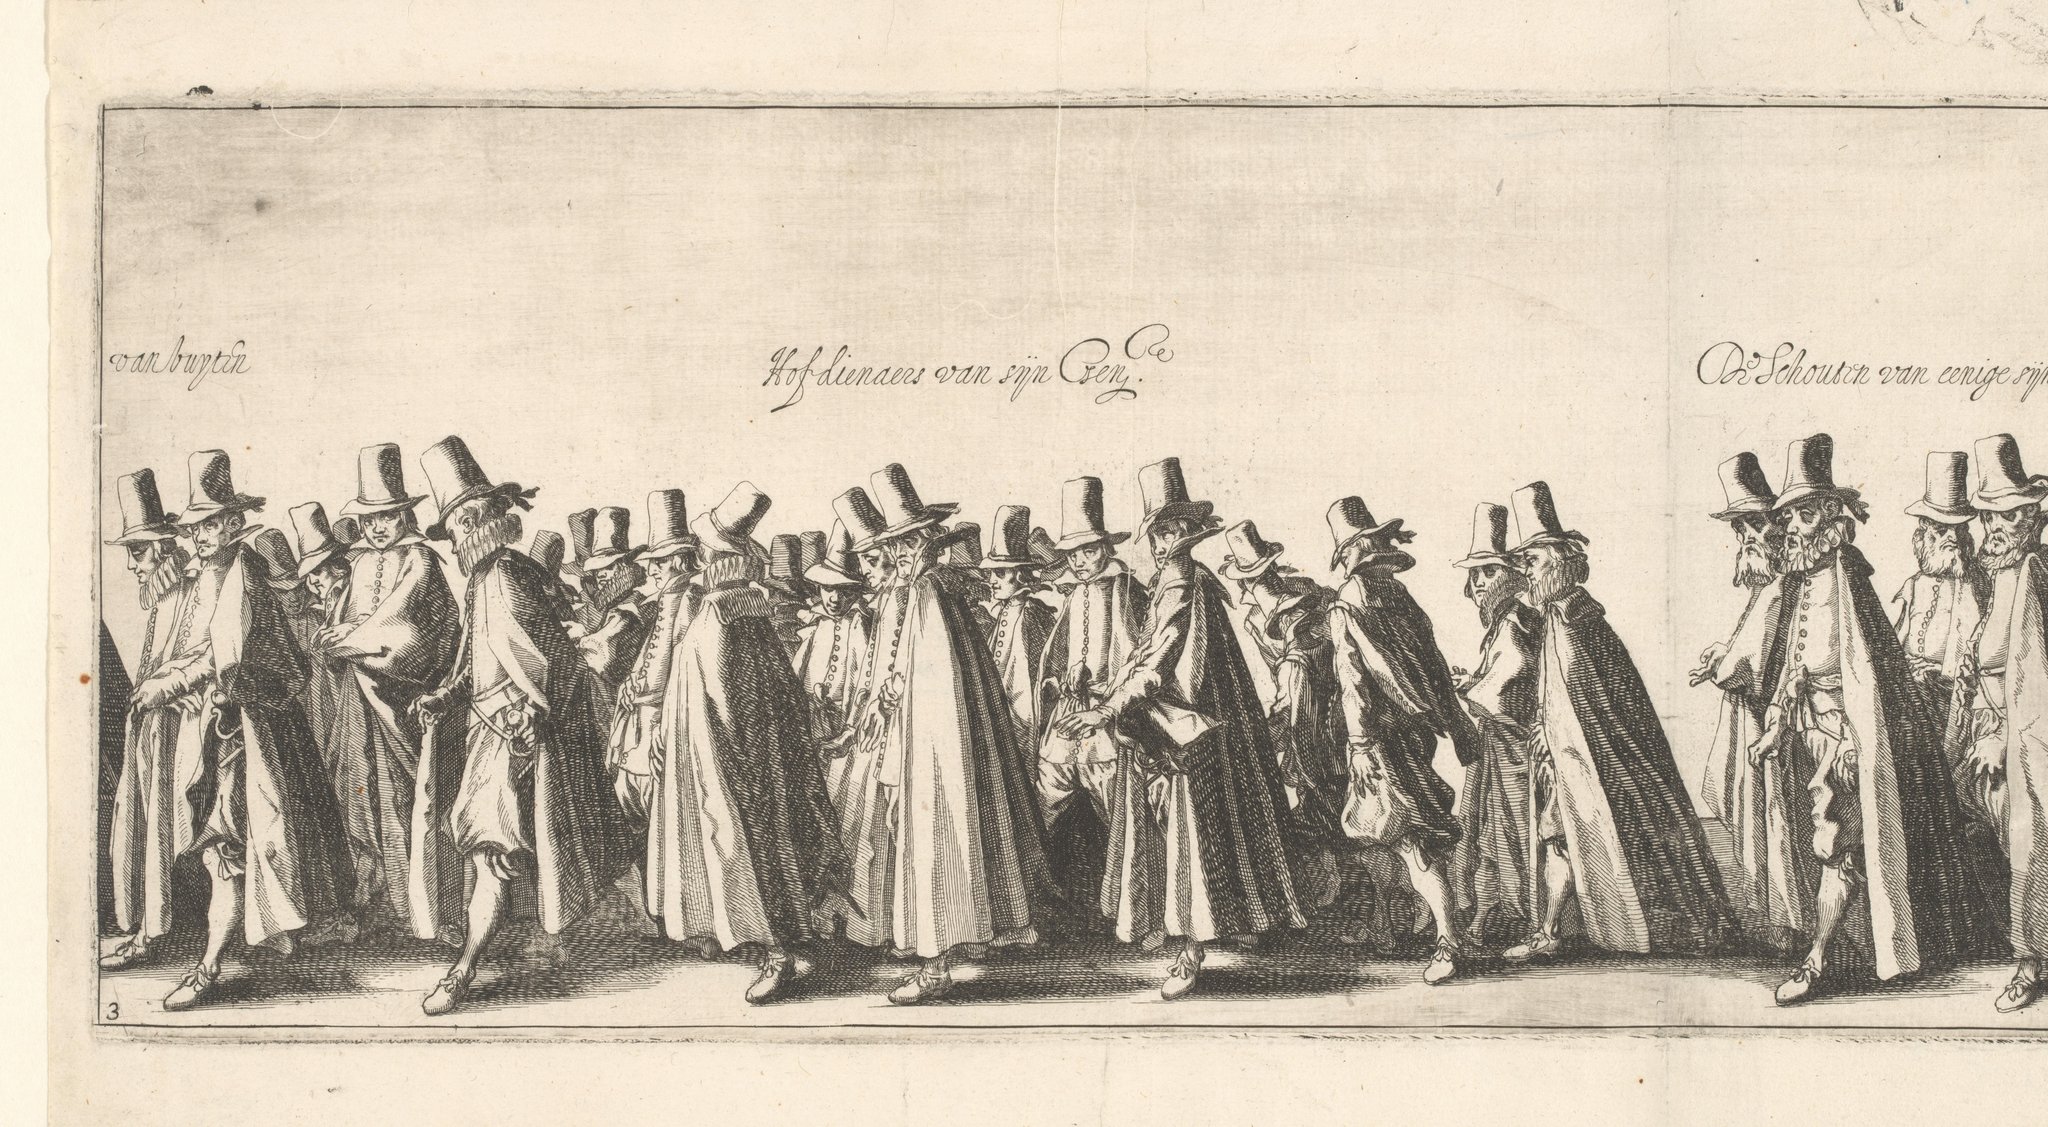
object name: print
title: Begrafenis van Walraven van Brederode, 1615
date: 1615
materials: paper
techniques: etching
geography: northern netherlands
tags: cortege, funeral procession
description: De begrafenisstoet (plaat 3). Hofdienaren en en schouten van enige van de heerlijkheden. Onderdeel van de serie prenten van de begrafenisoptocht van Walraven van Brederode, heer van Vianen, op 29 januari 1615 te Vianen.